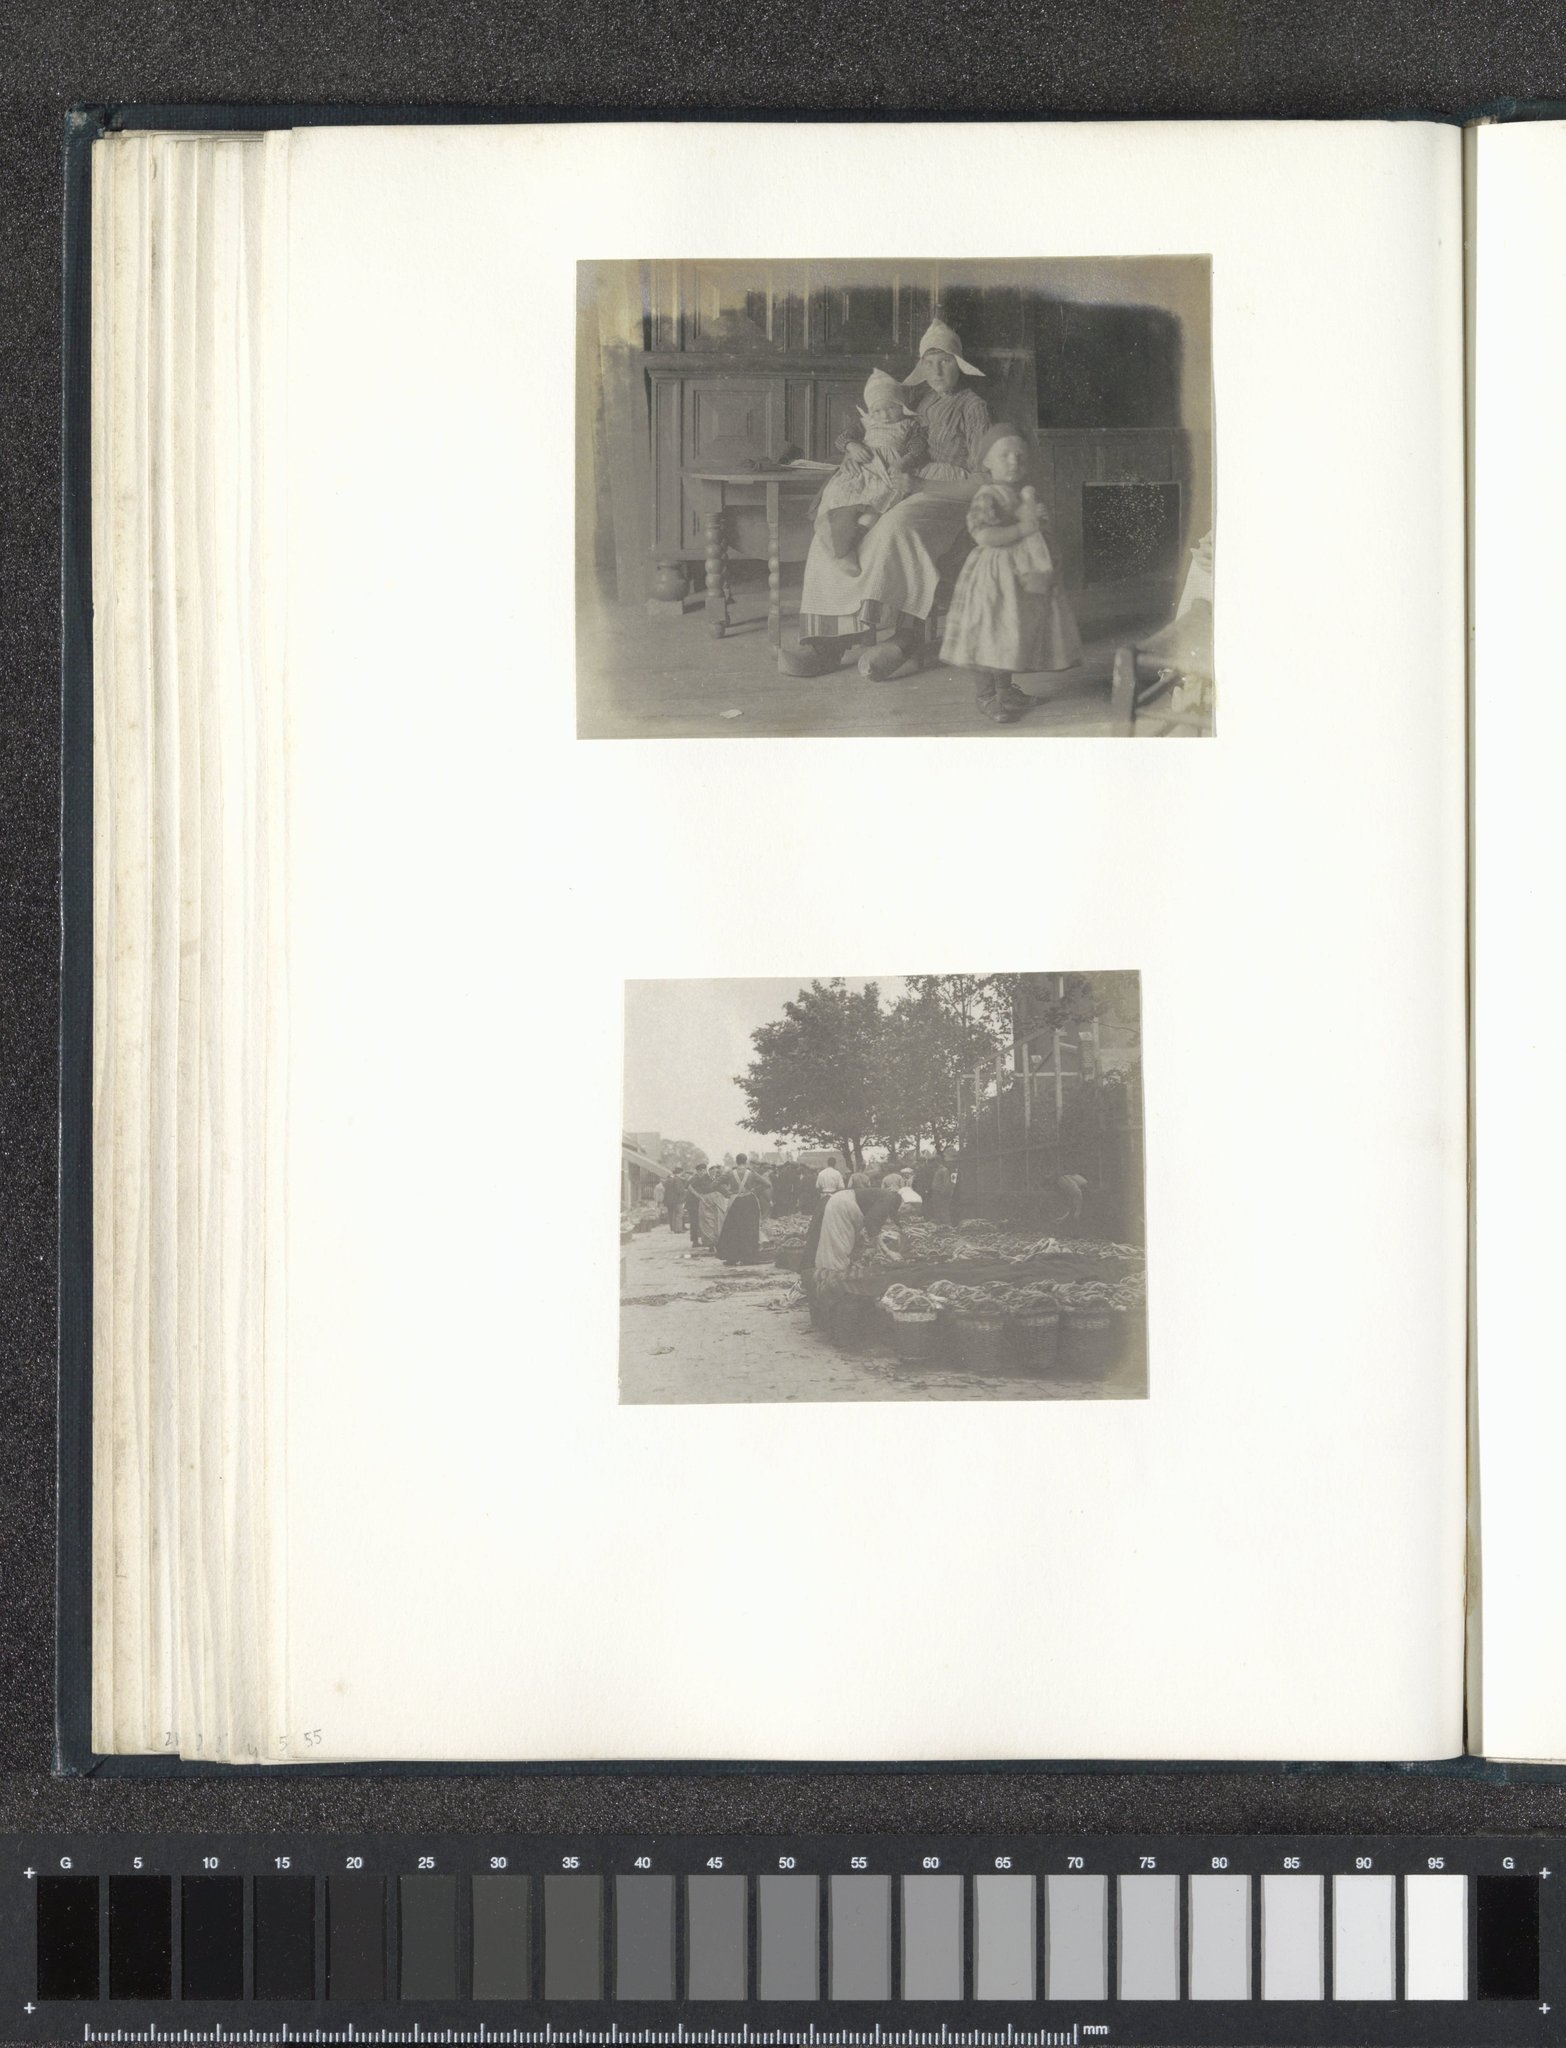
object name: photograph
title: Portret van een vrouw met twee kinderen in Volendamse klederdracht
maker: george hidderley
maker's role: fotograaf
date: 1900-1910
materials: paper, photographic support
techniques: gelatin silver print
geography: volendam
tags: folk costume, regional costume (+ women's clothes), mother and baby or young child, living-room, parlour, sitting-room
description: Onderdeel van fotoalbum met opnames van Volendam, Dordrecht, Gorinchem en Woudrichem.